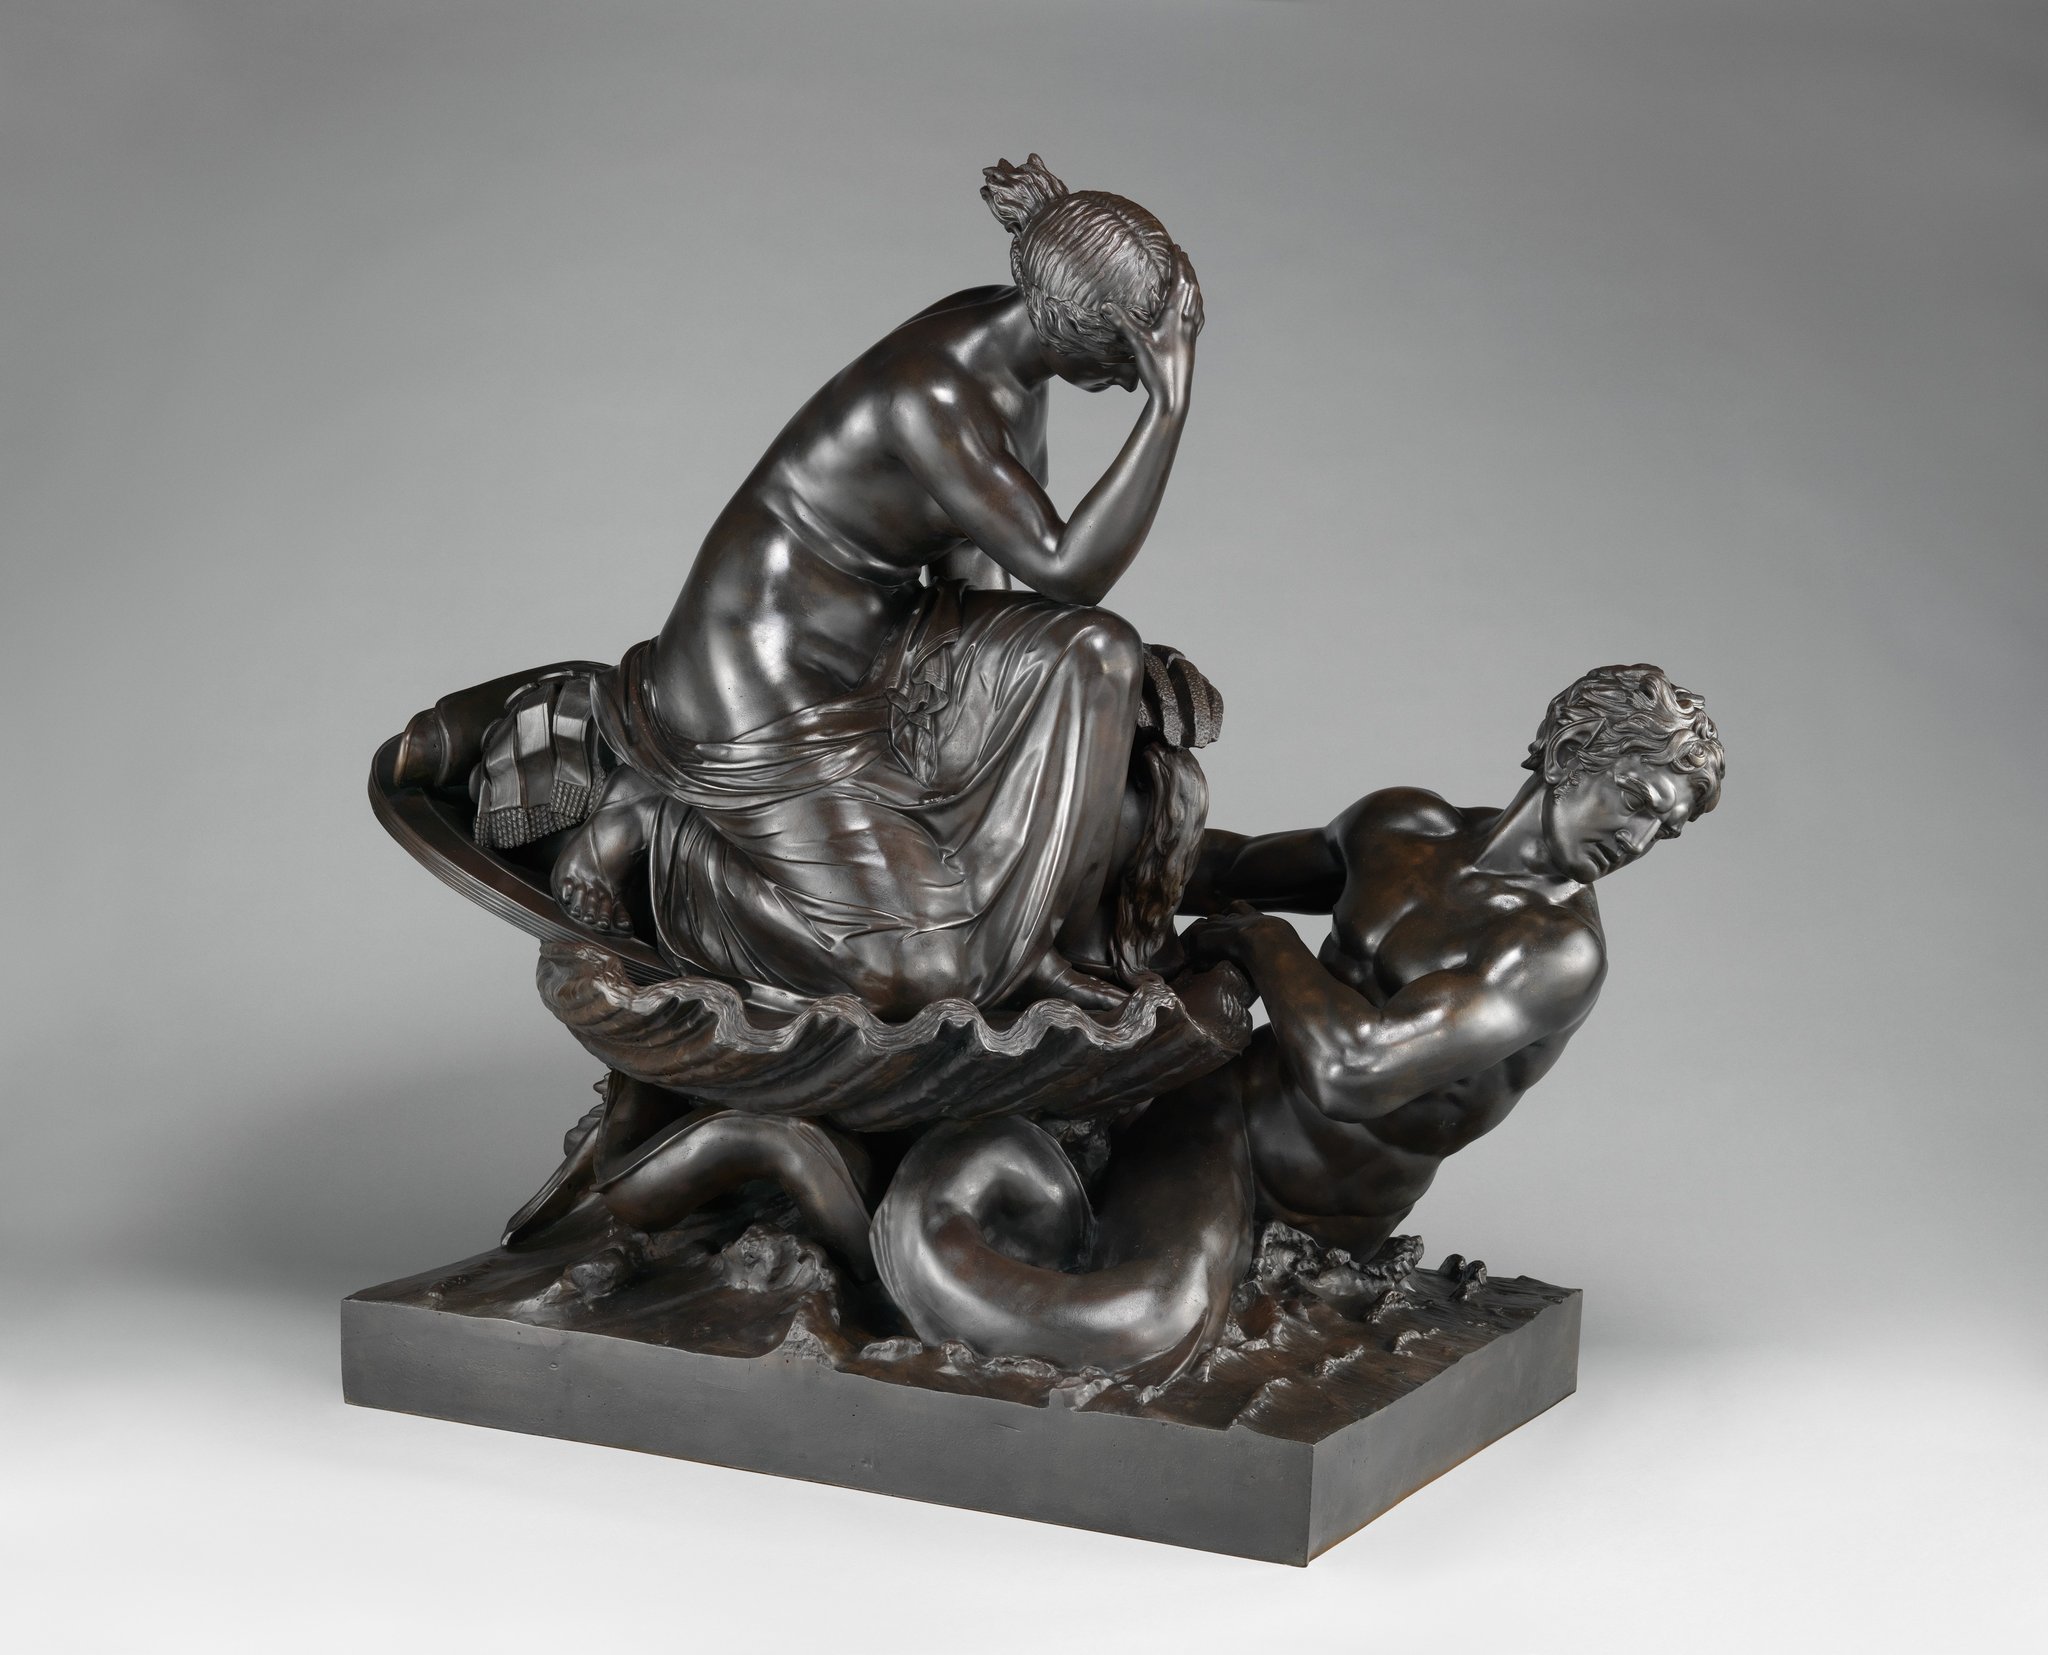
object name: group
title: Thetis Transporting Arms for Achilles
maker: william theed the elder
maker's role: artist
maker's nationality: british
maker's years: 1764-1817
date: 1804-1812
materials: bronze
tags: sadness,men,women